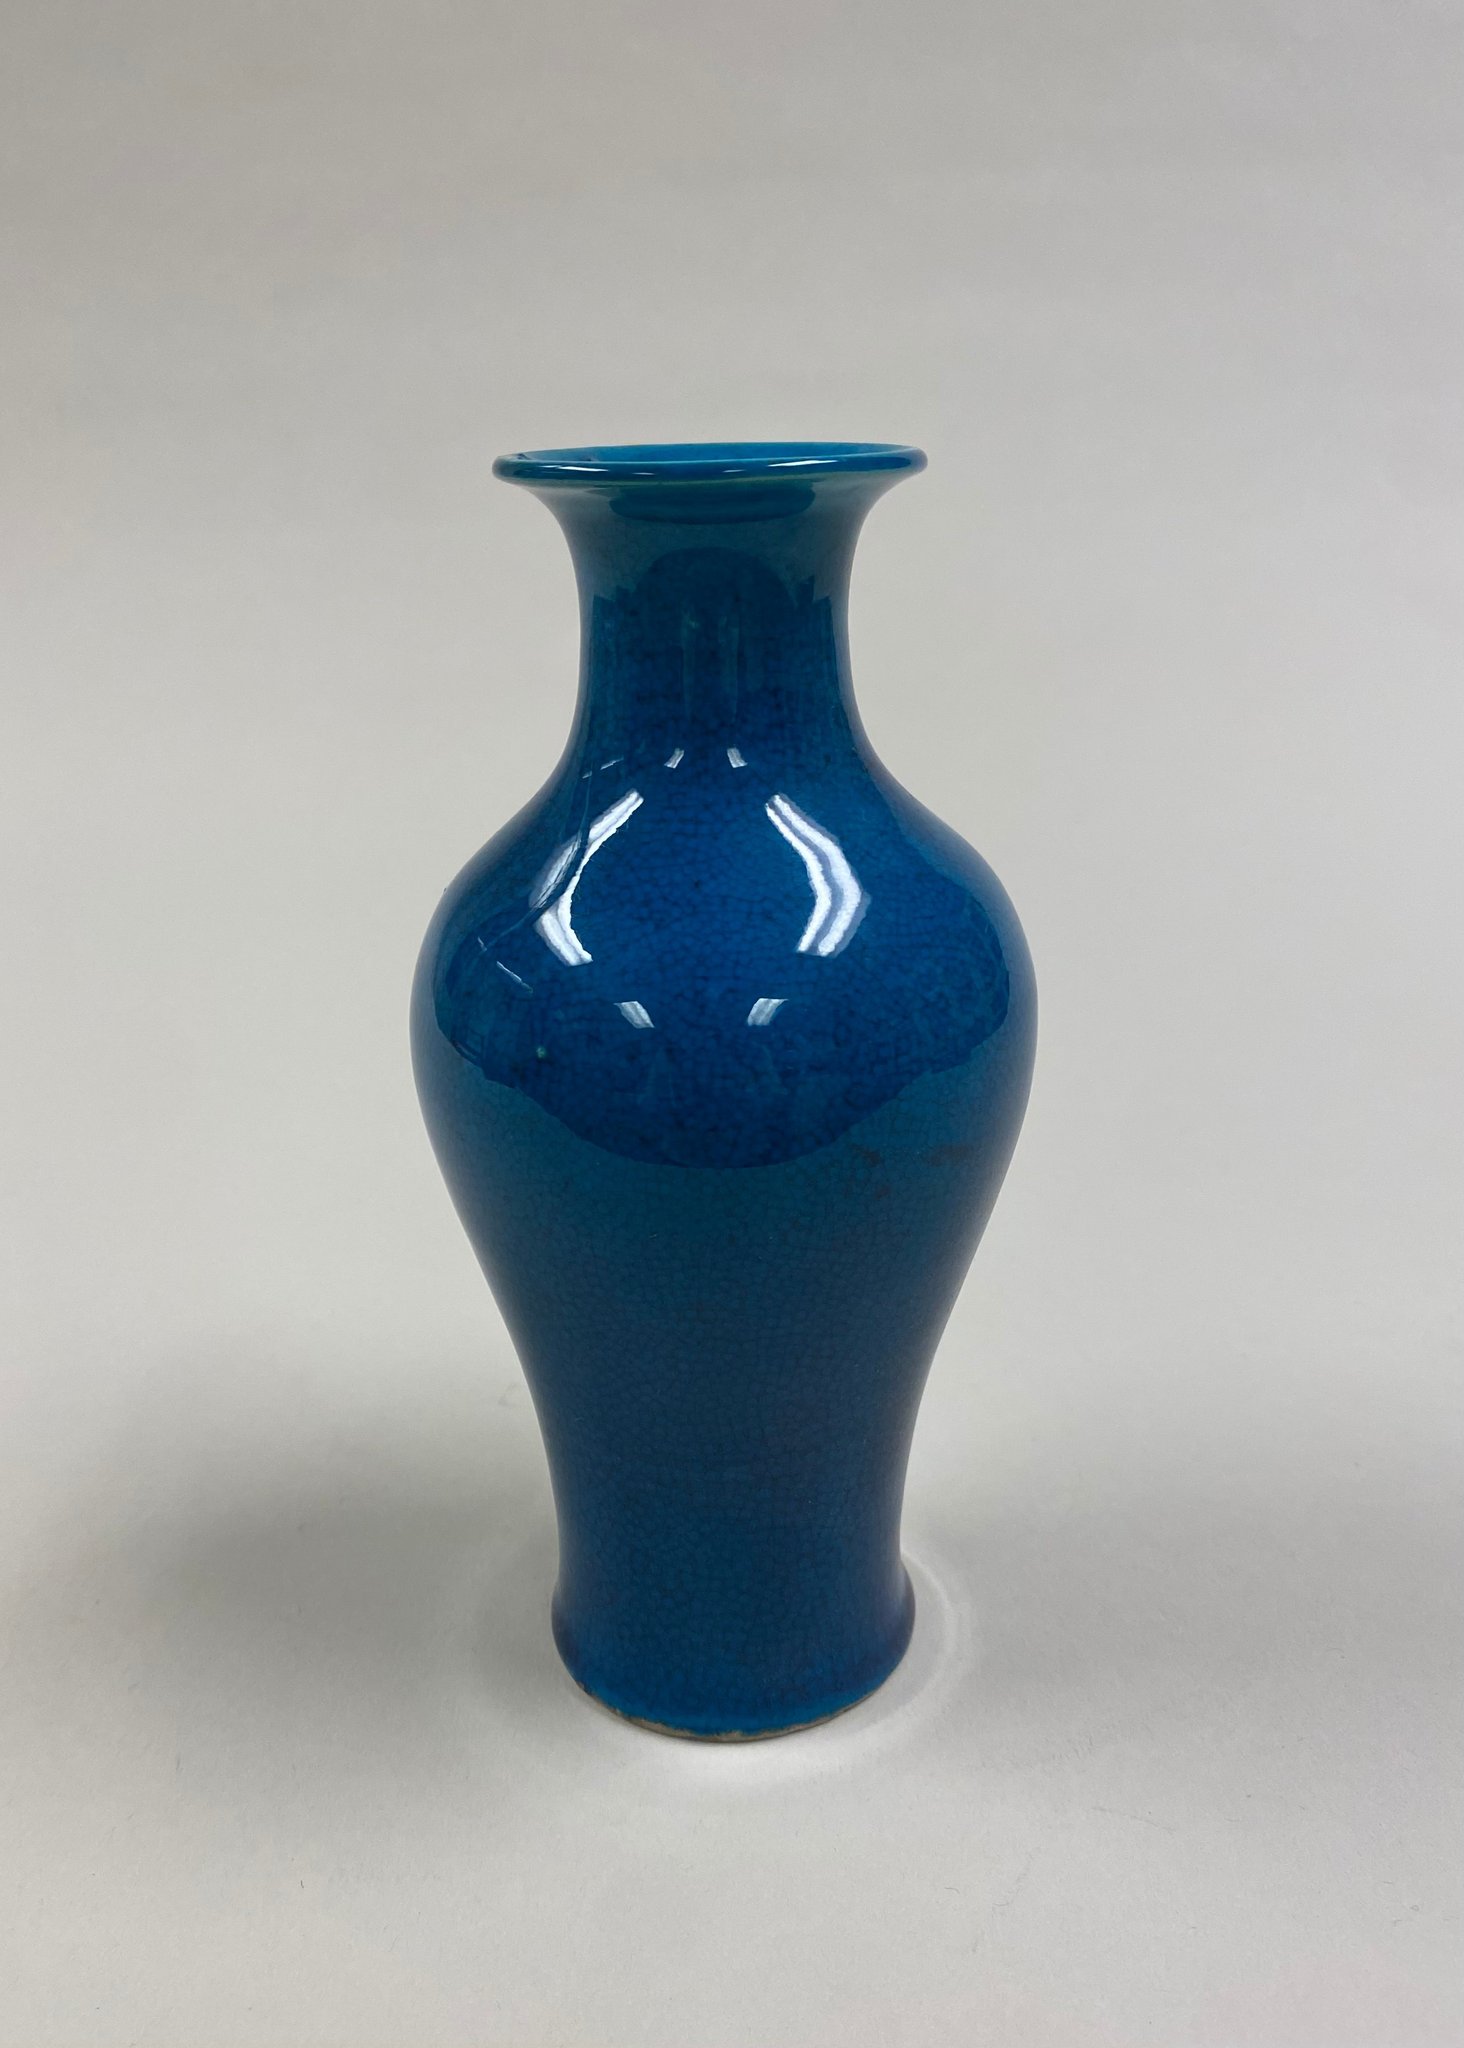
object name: vase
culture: chinese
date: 1701-1800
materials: glaze, porcelain